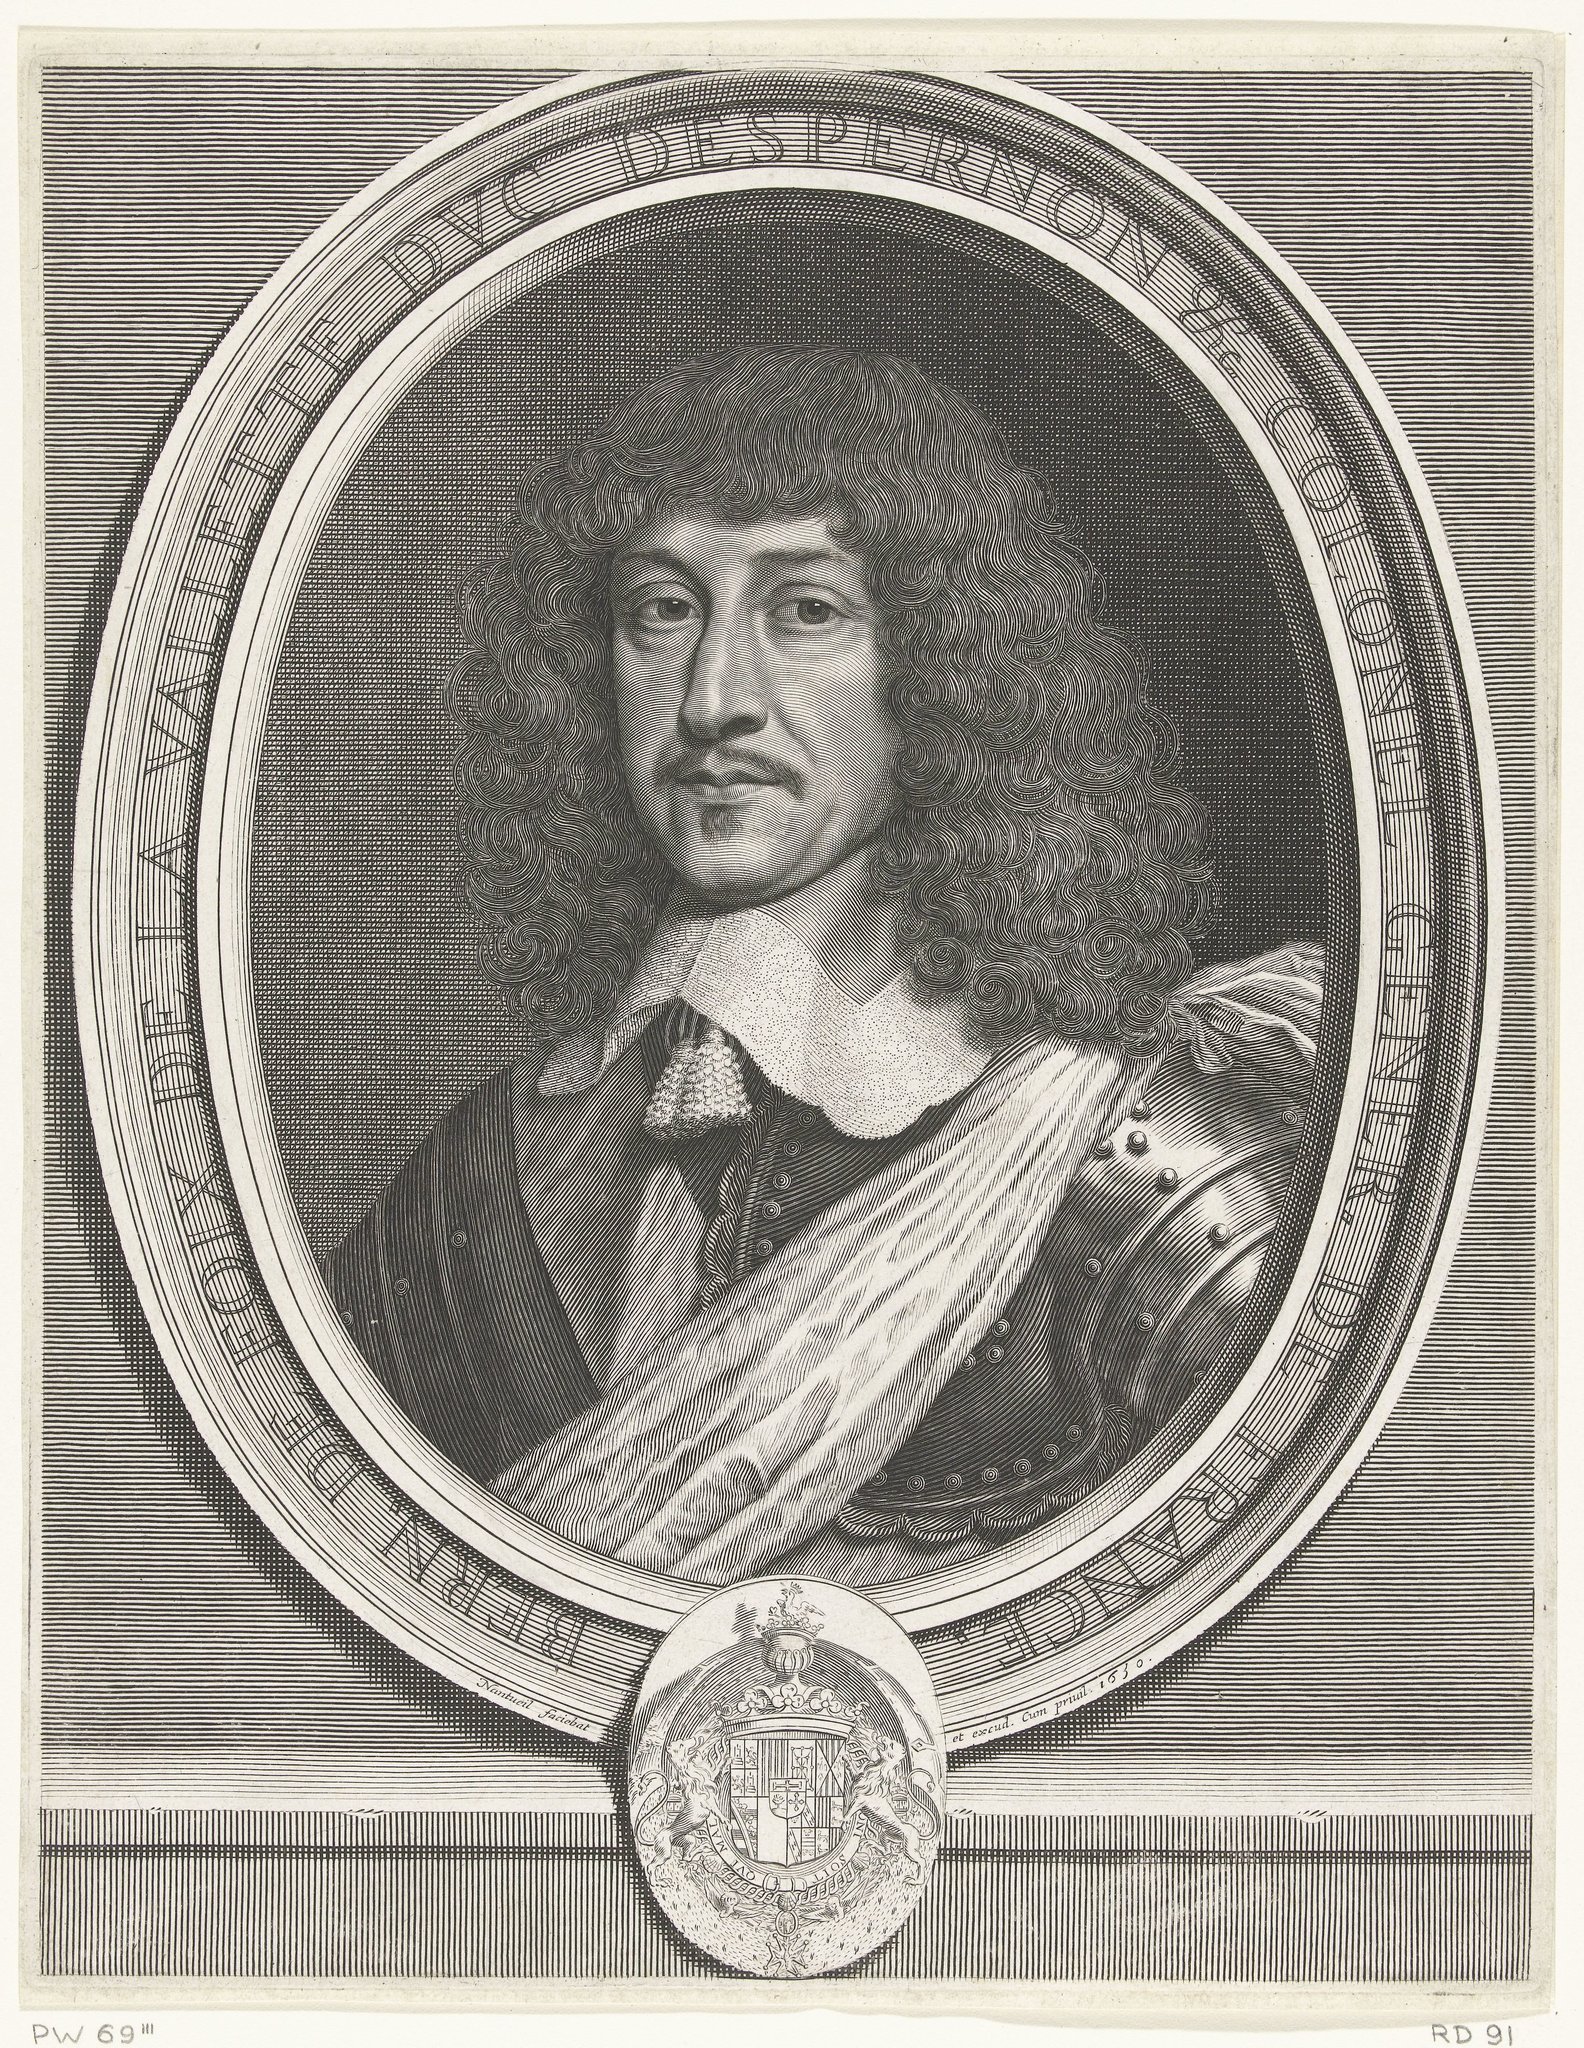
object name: print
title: Portret van Bernard de Foix de la Valette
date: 1650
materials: paper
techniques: engraving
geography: france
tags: paris, bernard de foix de la valette hertog van epernon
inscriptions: collector's mark: Lugt 2228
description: Portret van Bernard de Foix de la Valette, hertog van Epernon, in een harnas, met een sjerp om. Een ovale omlijsting met tekst en onderaan een wapenschild.